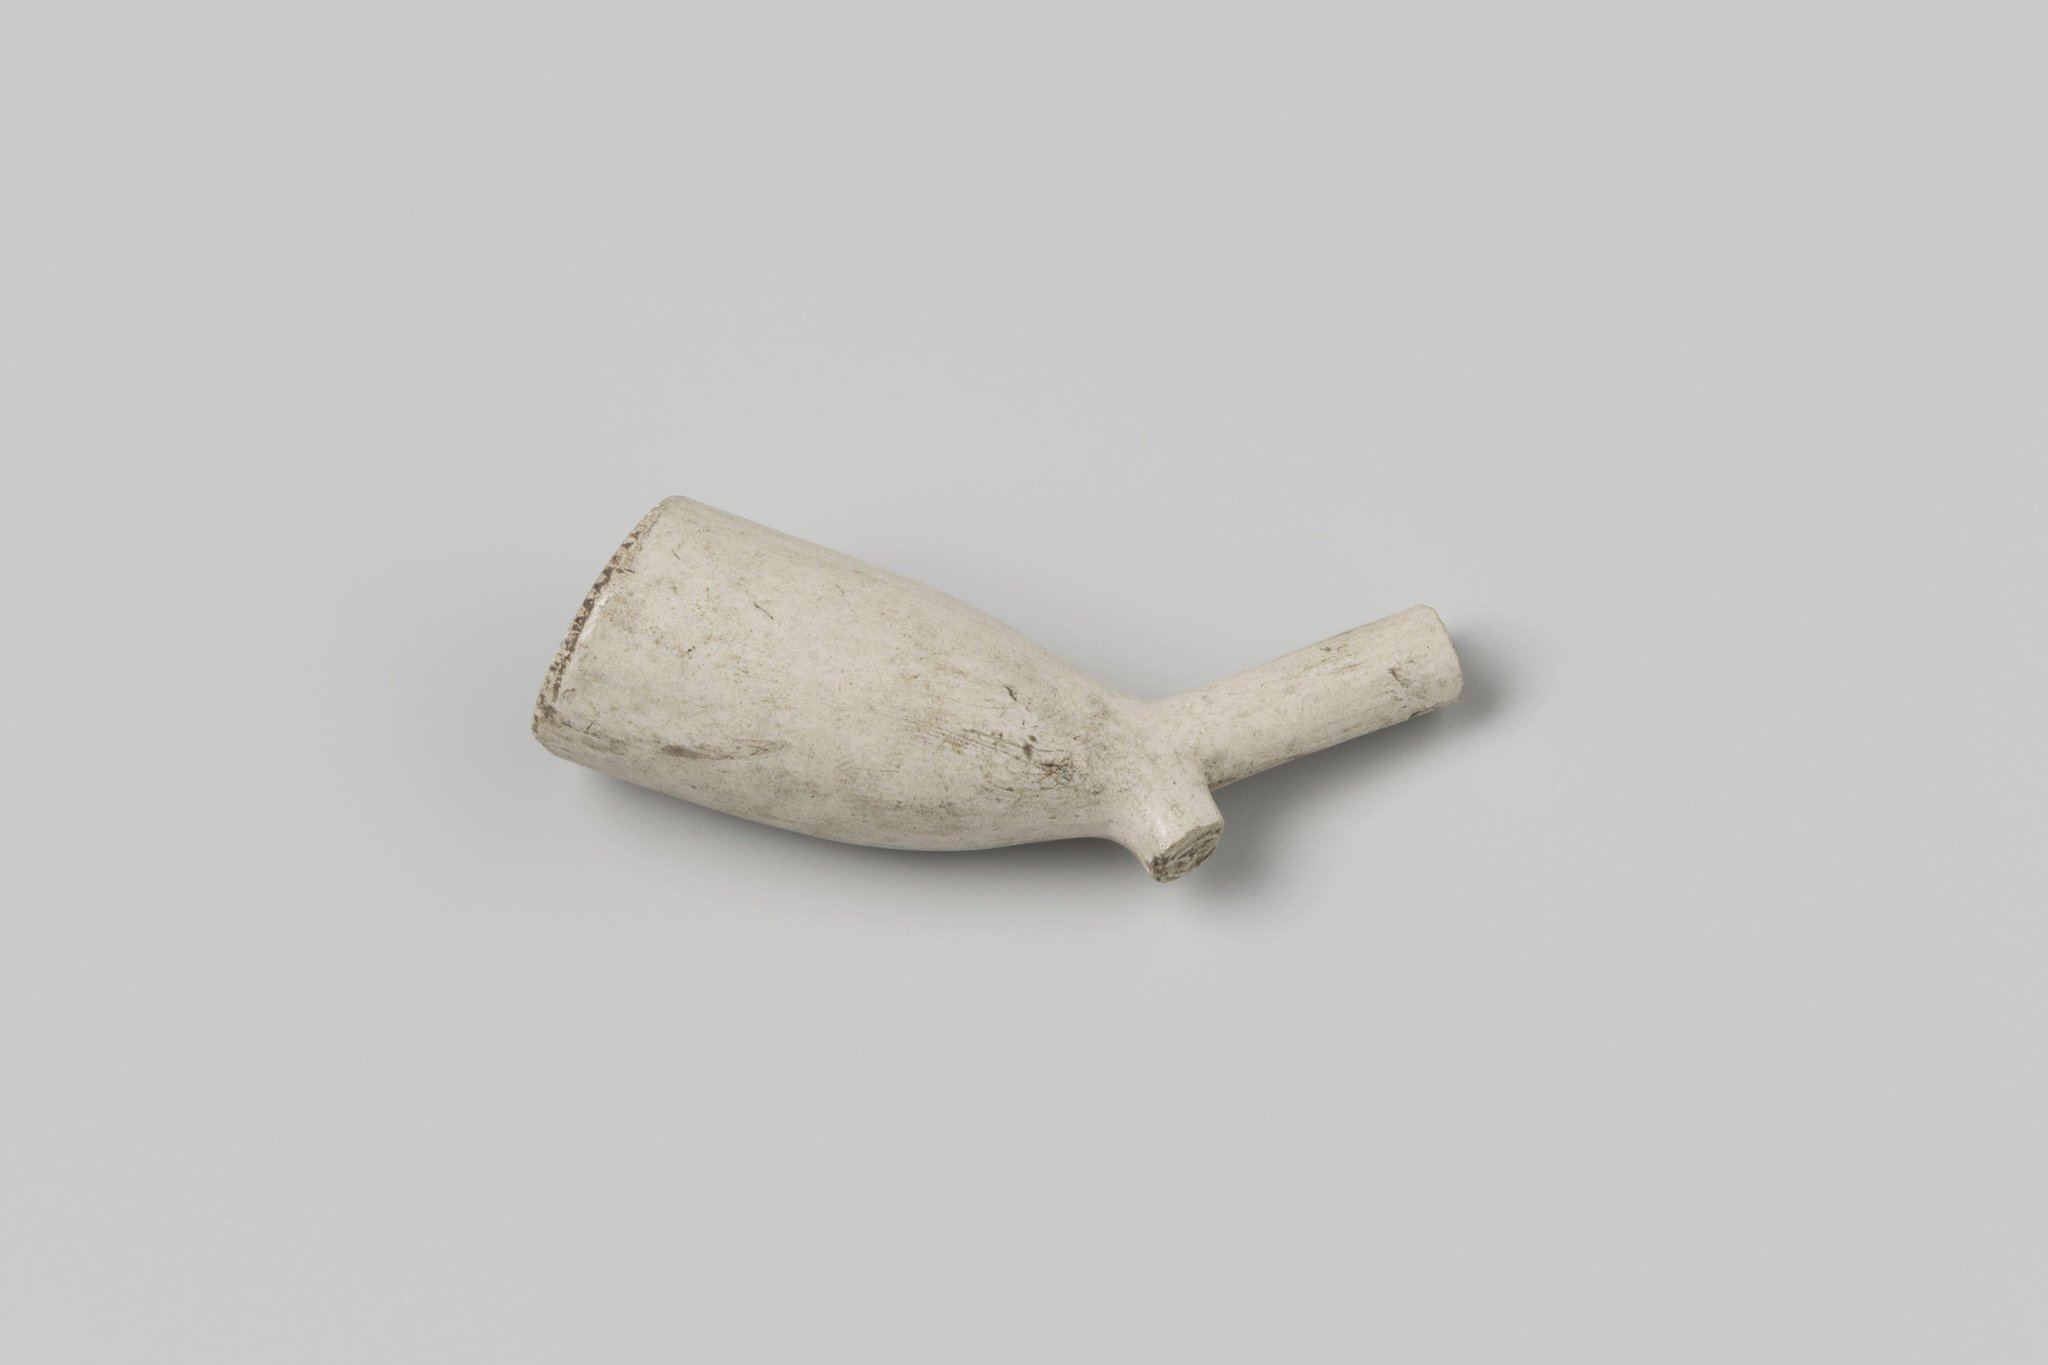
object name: fragment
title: Fragment tabakspijp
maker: Anonymous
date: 1720-1735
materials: clay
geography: gouda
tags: the hague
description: Fragment tabakspijp. Van de opgravingen op de Hofstede Arentsburg 1827-1831 onder toezicht van Professor Reuvens.